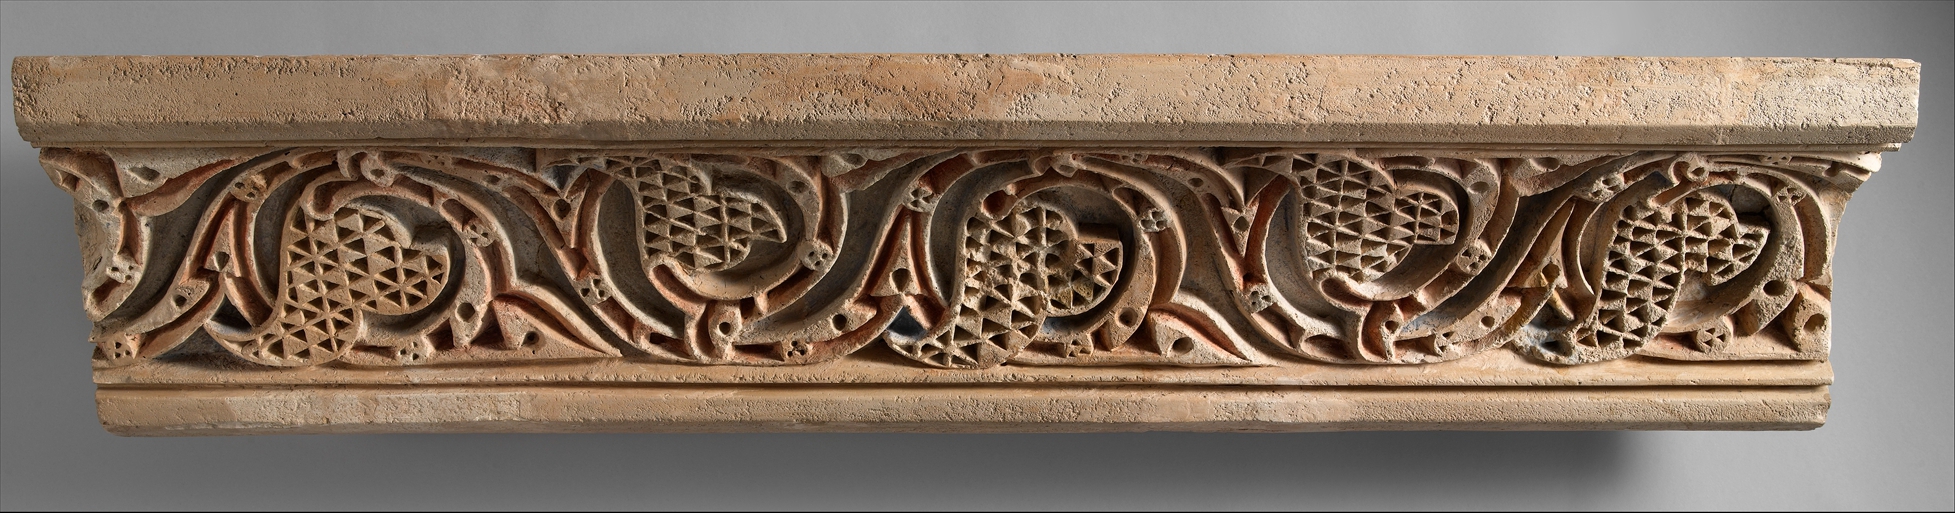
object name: fragment of a cornice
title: Fragment of a Painted Cornice Panel with Scrolling Vines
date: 1001-1100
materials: plaster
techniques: carving, painting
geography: iran